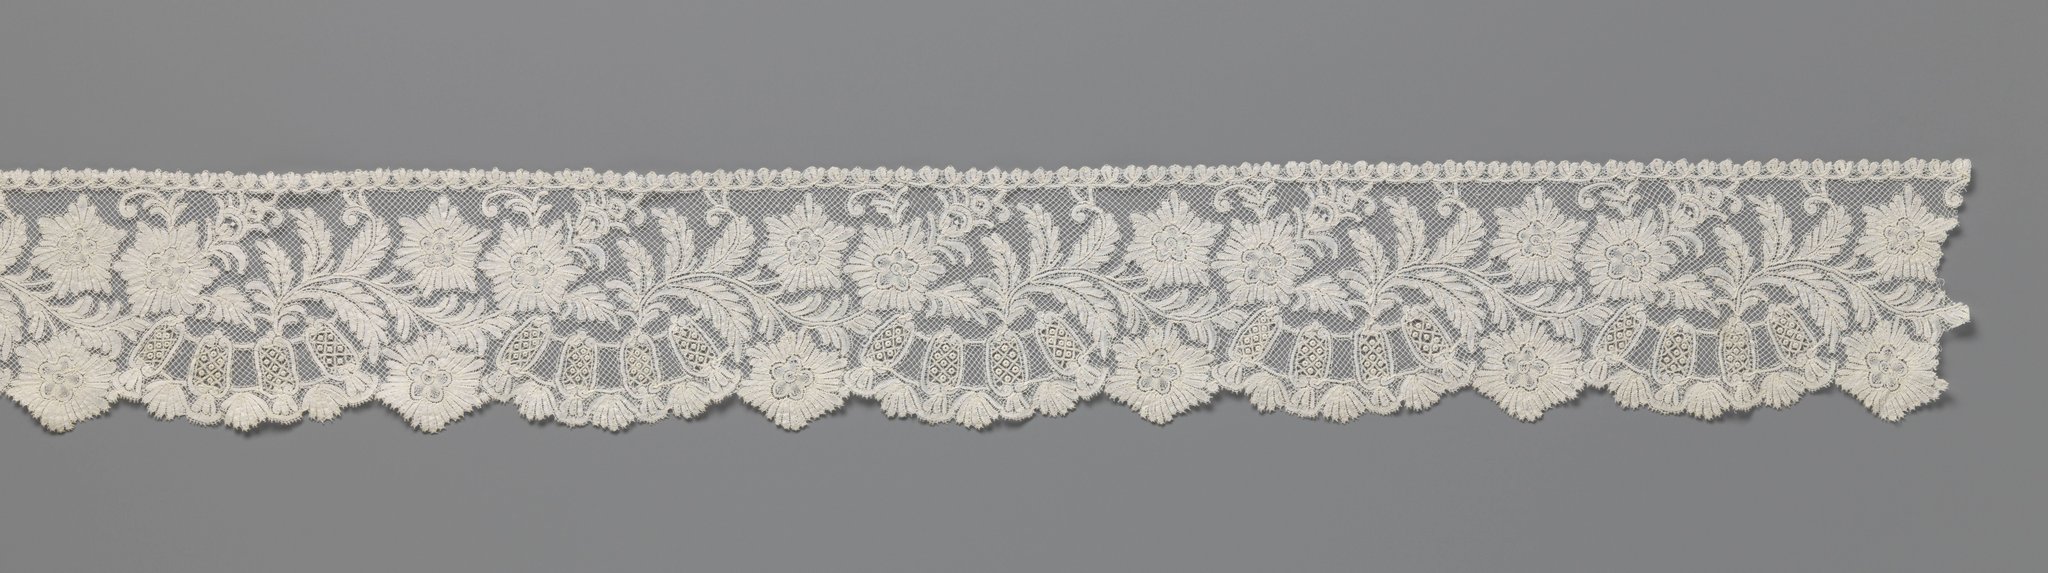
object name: strip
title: Strook kloskant met gegodronneerde schulp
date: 1880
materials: linen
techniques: lace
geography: brussels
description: Een golvende tak met gevederde bladeren en drie stervormige bloemen groeit van rechts naar links. Een der bloemen is buitenwaarts gericht en vormt een kleine tussenschulp tussen grotere, die zijn opgebouwd als een gegodronneerde boog of een gepijpte kraag met een open rasterwerkvulling (naaldkant). Als beëindiging van het fijne mazenfond (vierkante mazen) loopt langs de binnenkant een fijn randje van palmetjes, aangebracht als kanthoofdje. Brabantse Valenciennes-kant.